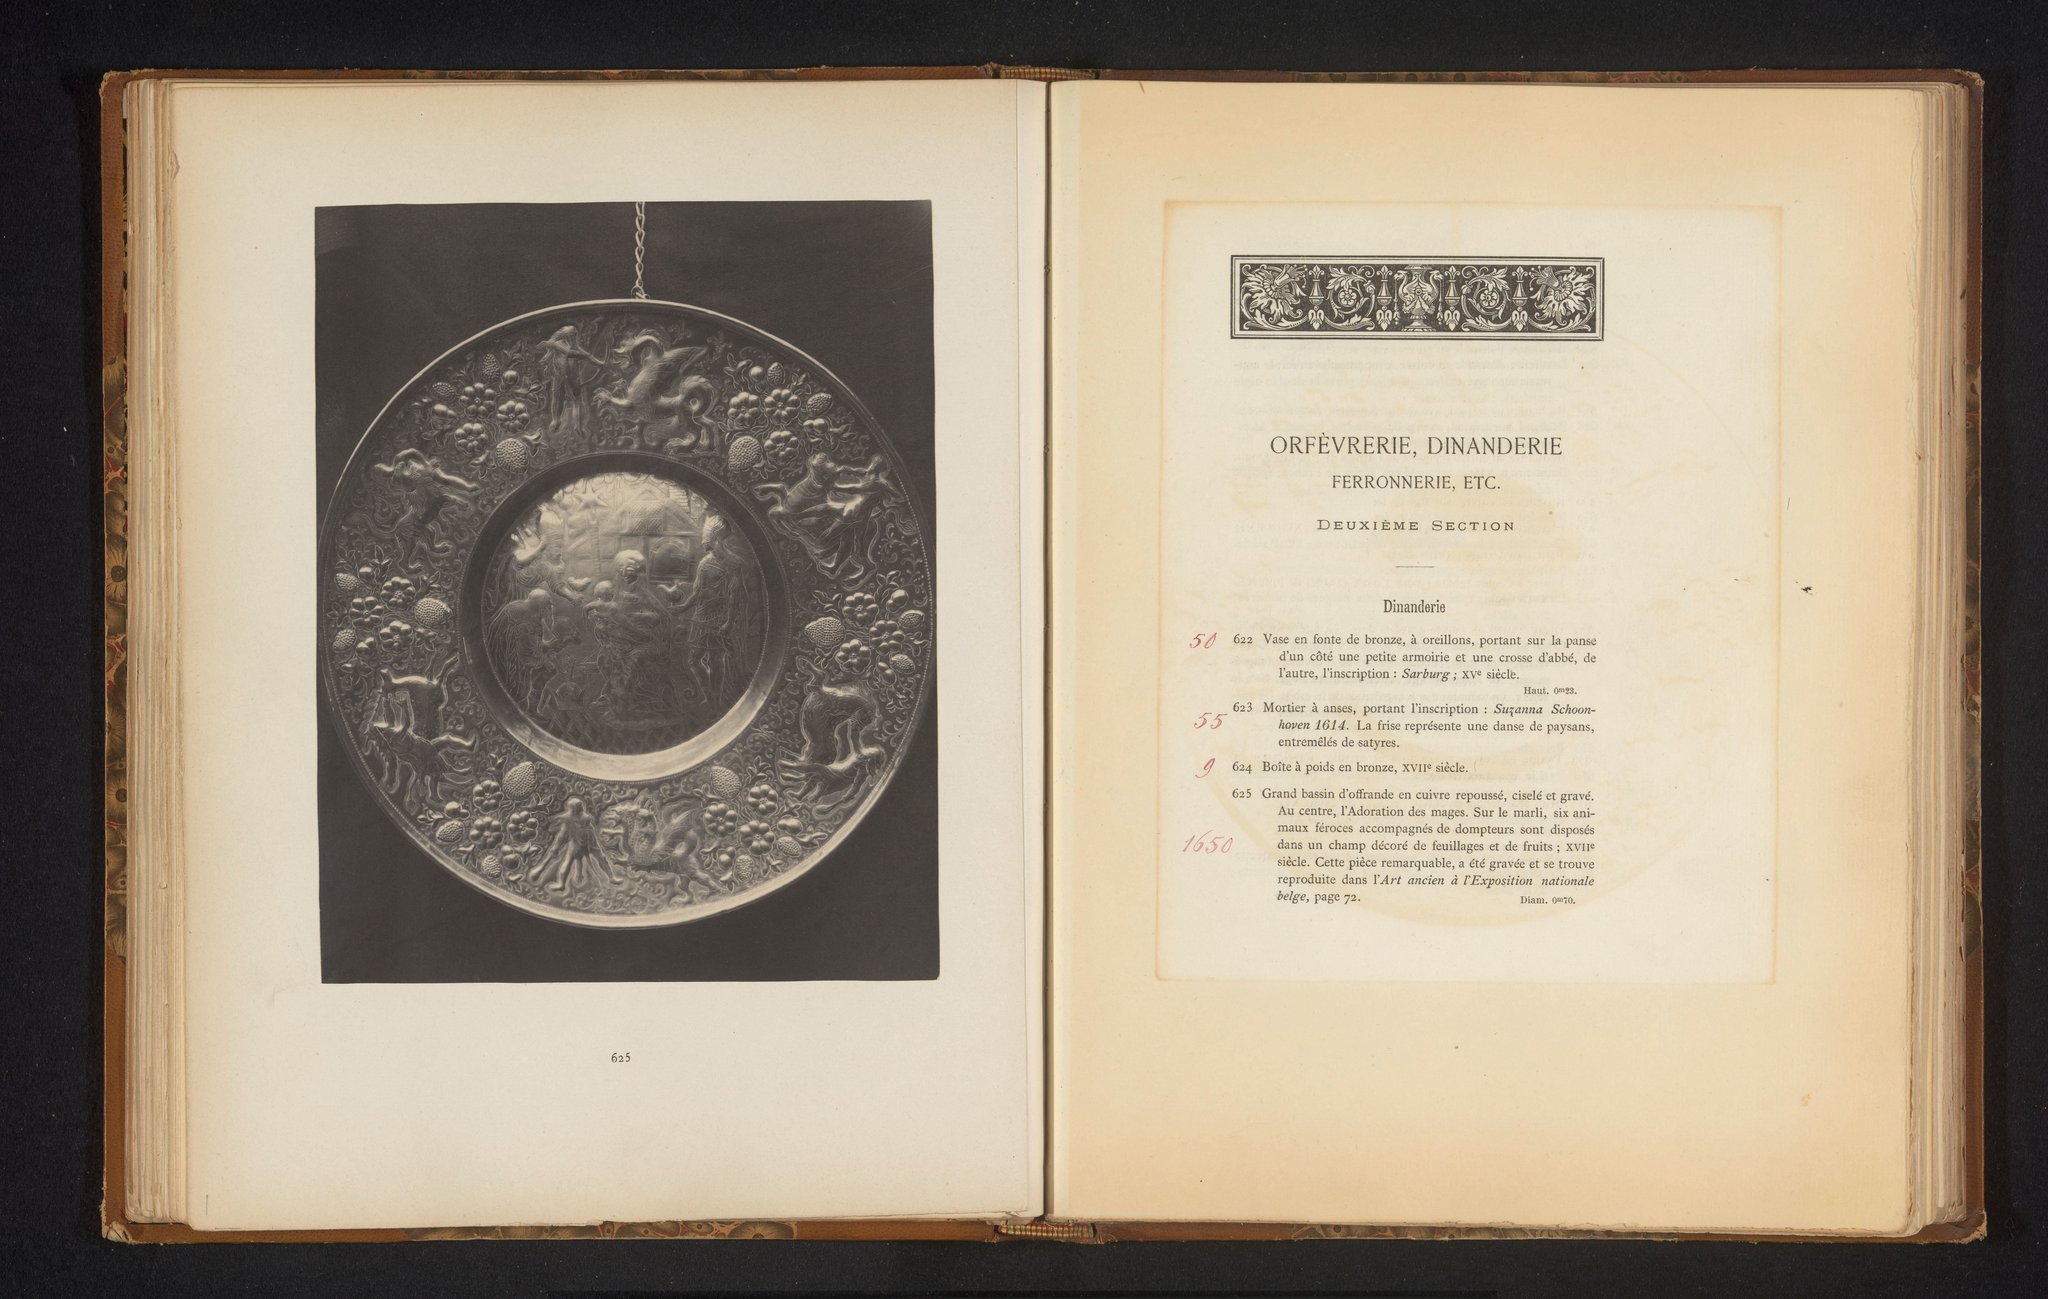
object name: page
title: Koperen schaal uit de collectie van Antonin Terme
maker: Anonymous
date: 1880-1885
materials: photographic support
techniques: platinum process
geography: liège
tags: art collection, art gallery, dish, plate, saucer, birth and youth of christ